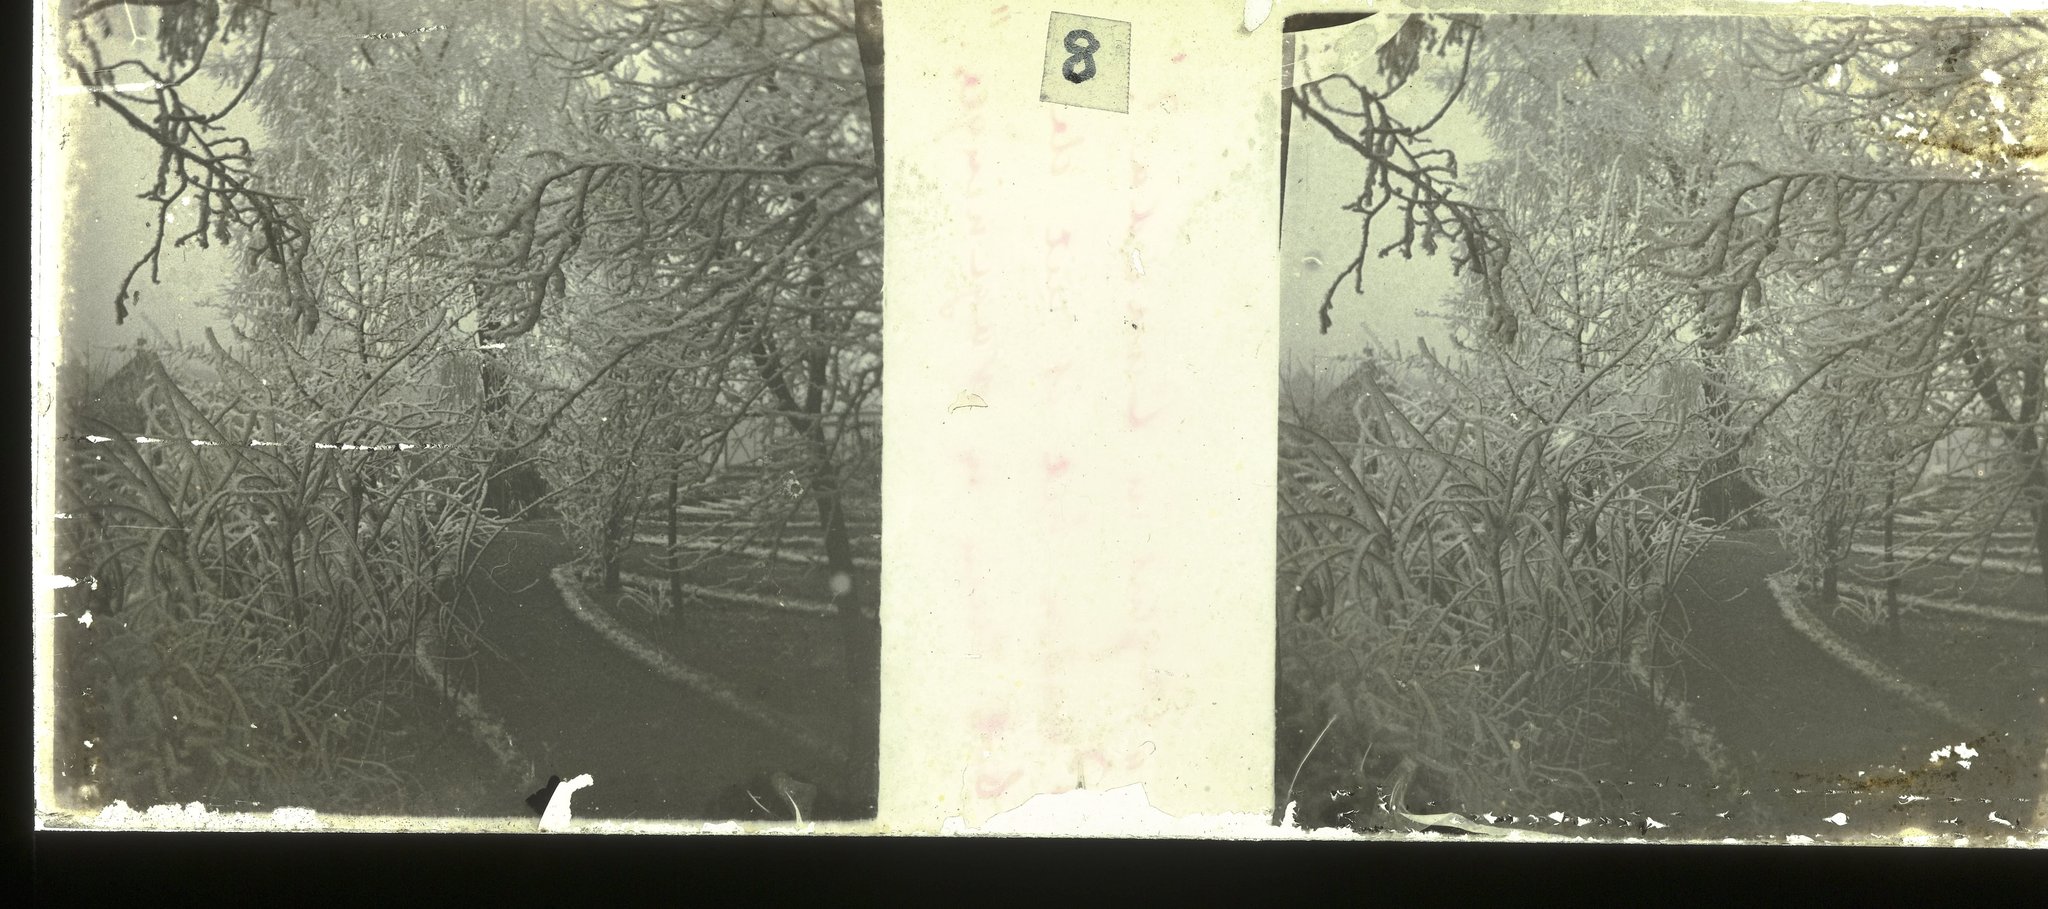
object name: stereograph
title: Winterlandschap in Nederland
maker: theodoor brouwers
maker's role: amateurfotograaf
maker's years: 1874-1932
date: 1913-1930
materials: glass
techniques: photography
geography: netherlands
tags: theodoor brouwers, netherlands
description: In de periode 1911-1932 woonde op plantage Accaribo in Suriname de familie Brouwers van wie de foto's afkomstig zijn. Rond 1910 vond Theodoor Brouwers werk op plantage Accaribo. In 1929 werd hij eigenaar van de plantage. Op Accaribo werden in zijn tijd bananen geproduceerd en wat koffie.